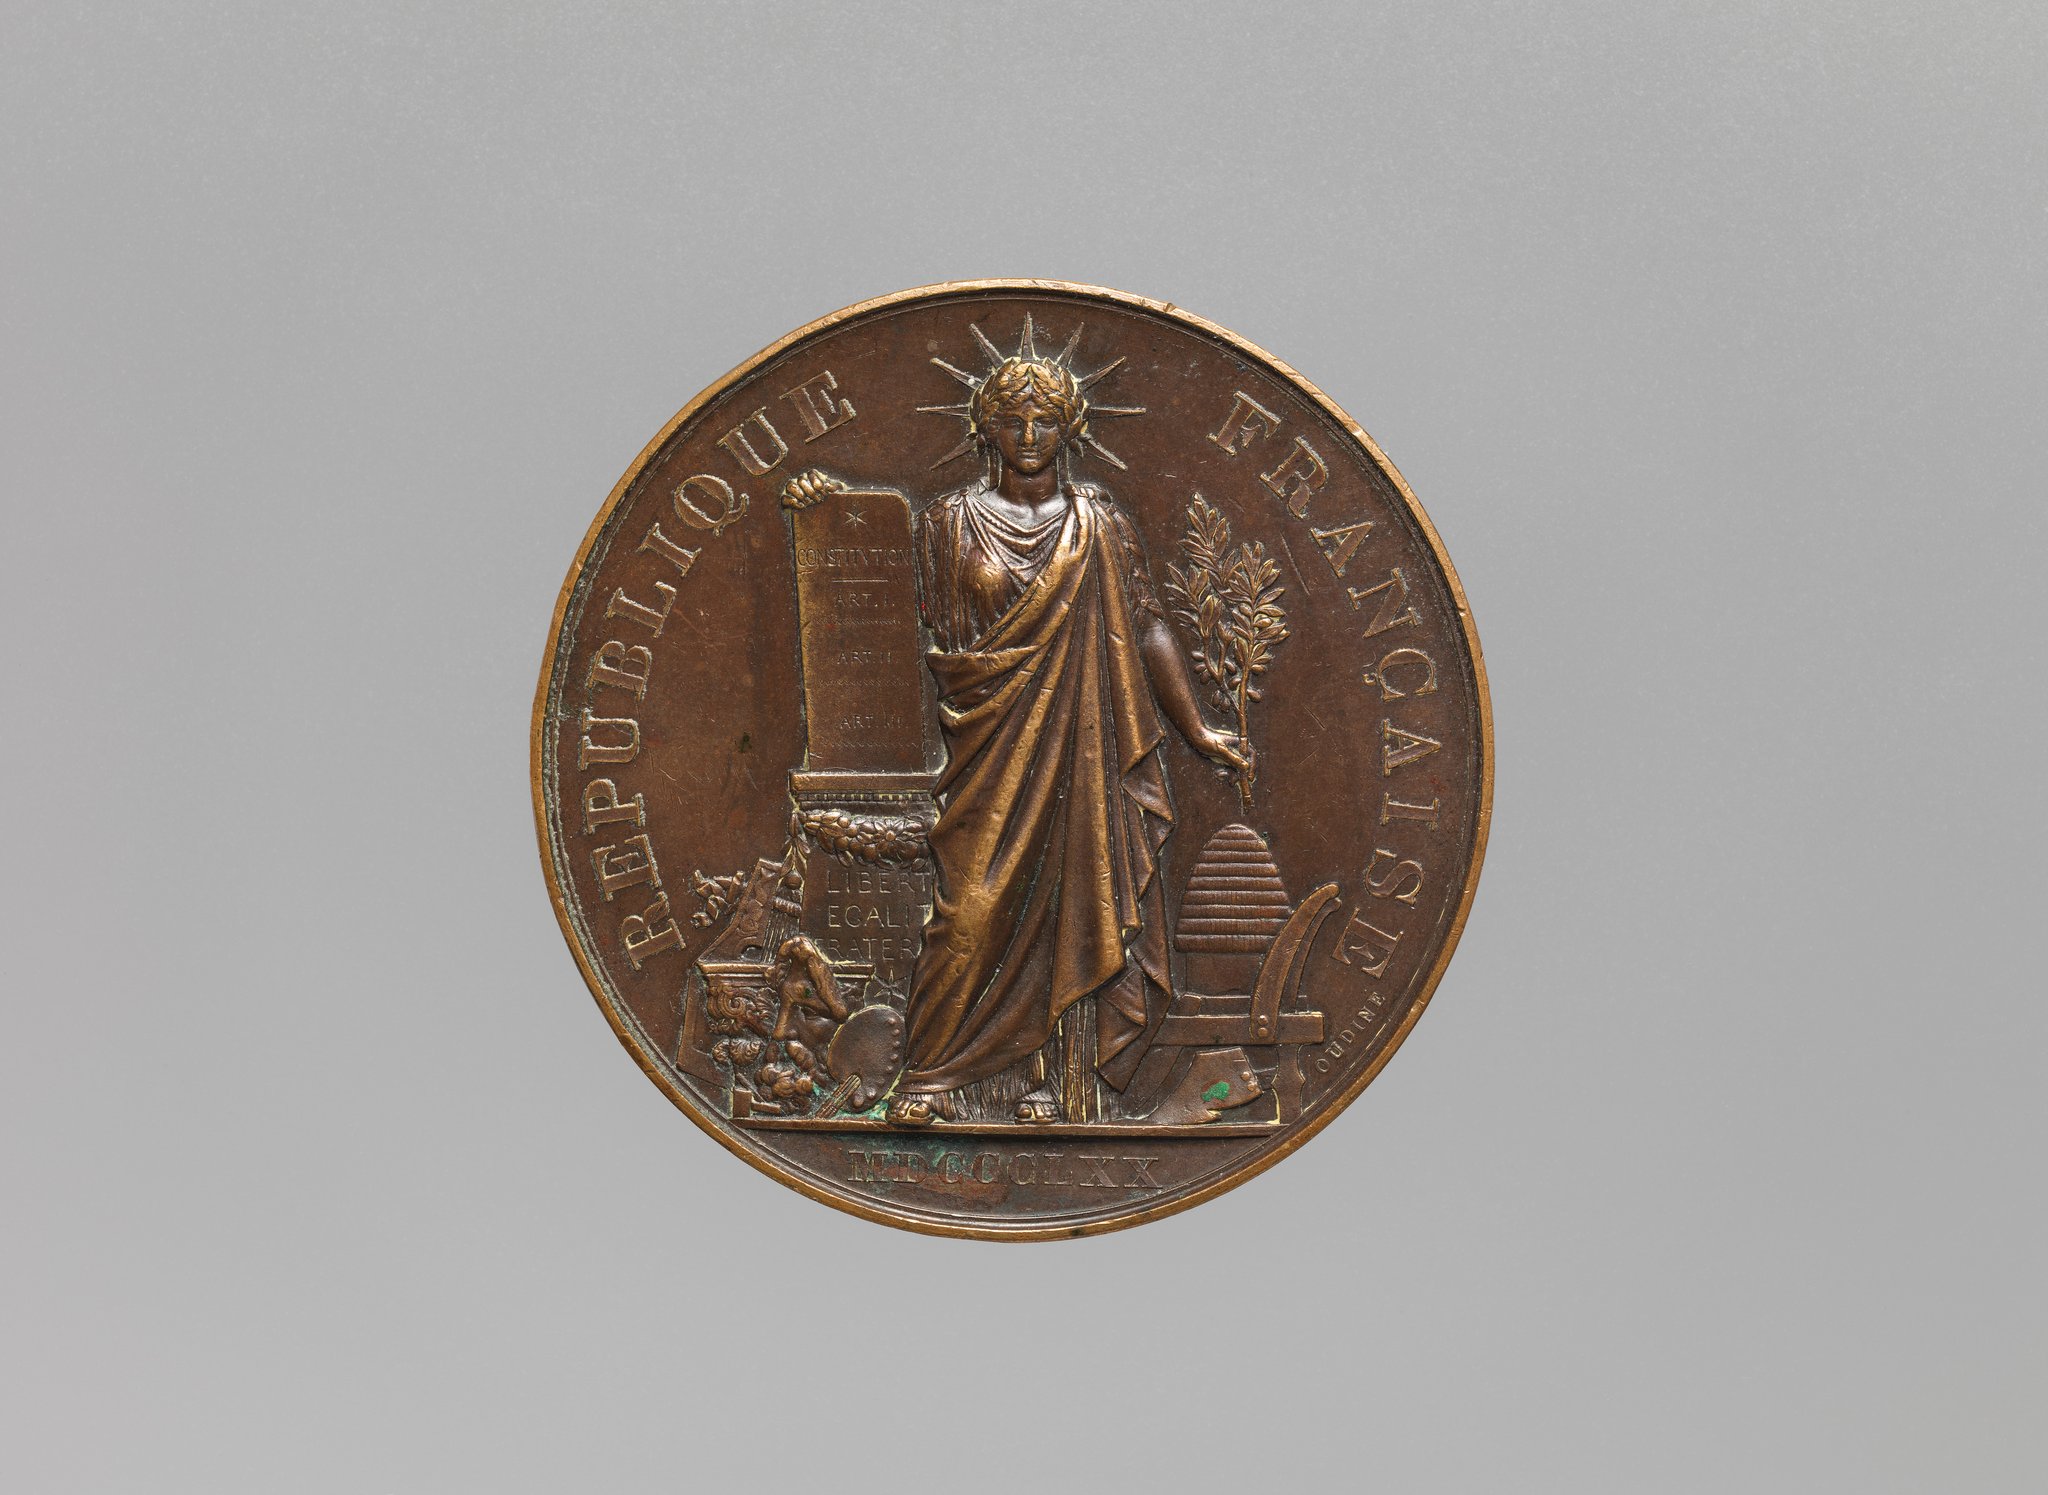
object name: medal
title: Medal Awarded to French Civilian Pigeon-Keepers (Colombiers civils)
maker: eugène-andré oudiné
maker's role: artist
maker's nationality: french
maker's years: 1810-1887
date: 1870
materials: copper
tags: women